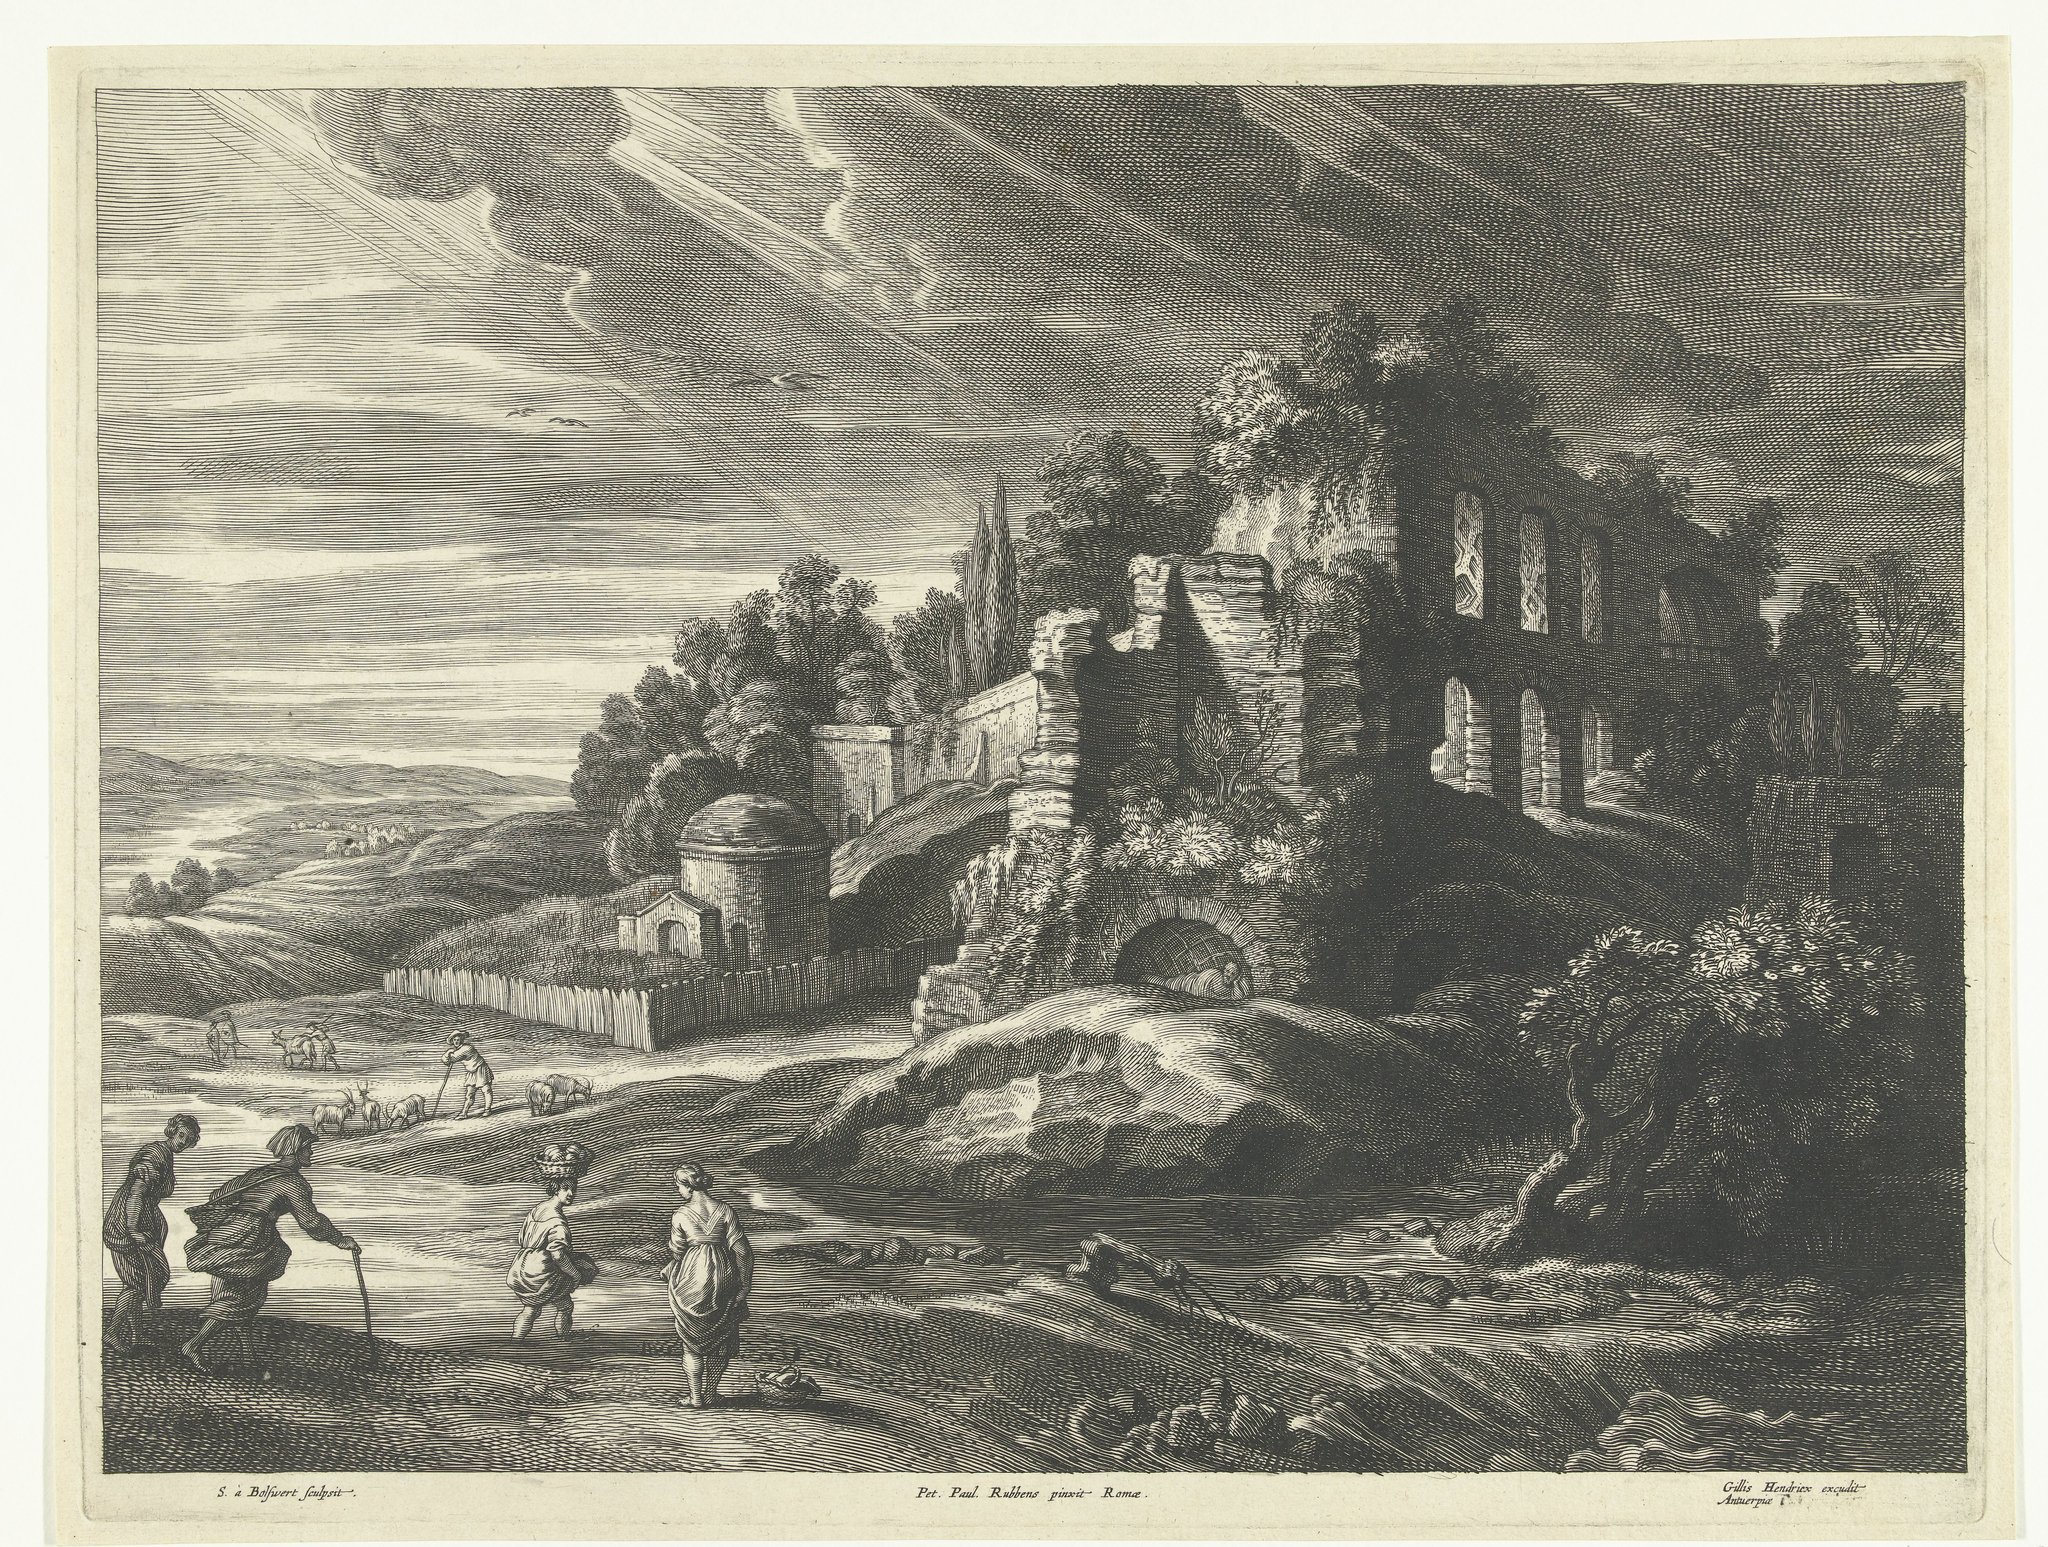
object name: print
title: Landschap met ruïnes en vrouwen bij beek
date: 1596-1659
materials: paper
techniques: engraving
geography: antwerp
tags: landscape with ruins, brook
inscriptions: collector's mark: Lugt 240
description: Prent naar schilderij van Peter Paul Rubens. Hollstein beschrijft een serie kleine landschappen onder de nrs. 305 t/m 325 maar deze prenten zijn niet als reeks vervaardigd.